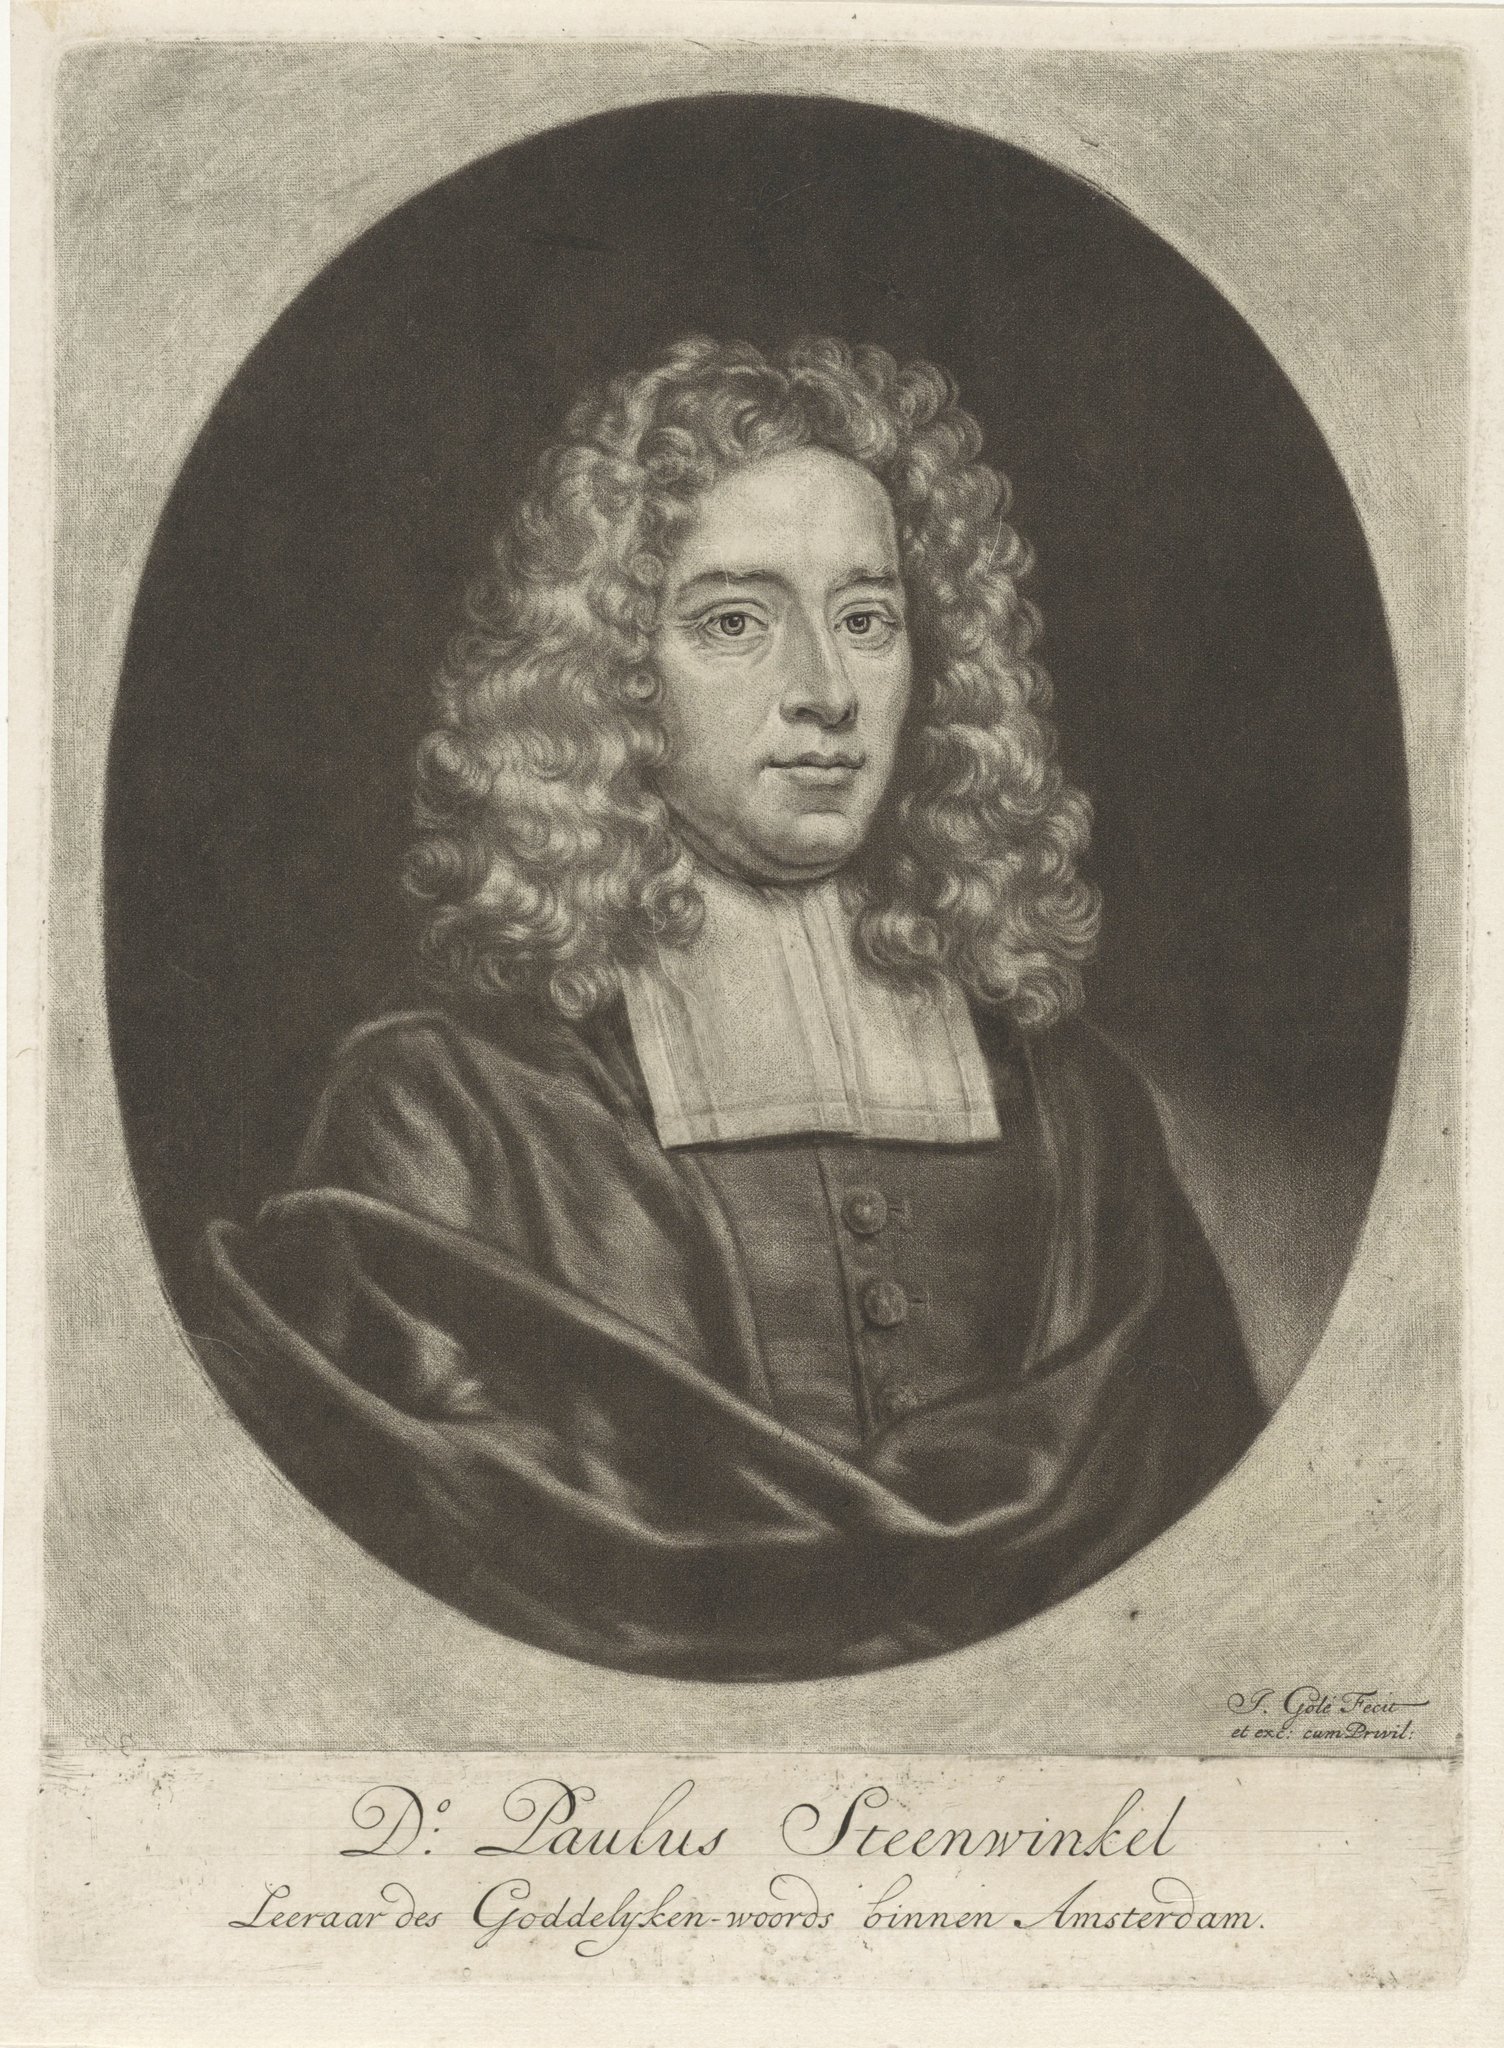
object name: print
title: Portret van Paulus Steenwinkel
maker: jacob gole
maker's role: print maker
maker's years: 1660-1724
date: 1670-1724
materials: paper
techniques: engraving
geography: amsterdam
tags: wijk bij duurstede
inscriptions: collector's mark: Lugt 2228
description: Paulus Steenwinkel, predikant te Den Bosch, Amsterdam en andere Nederlandse steden.